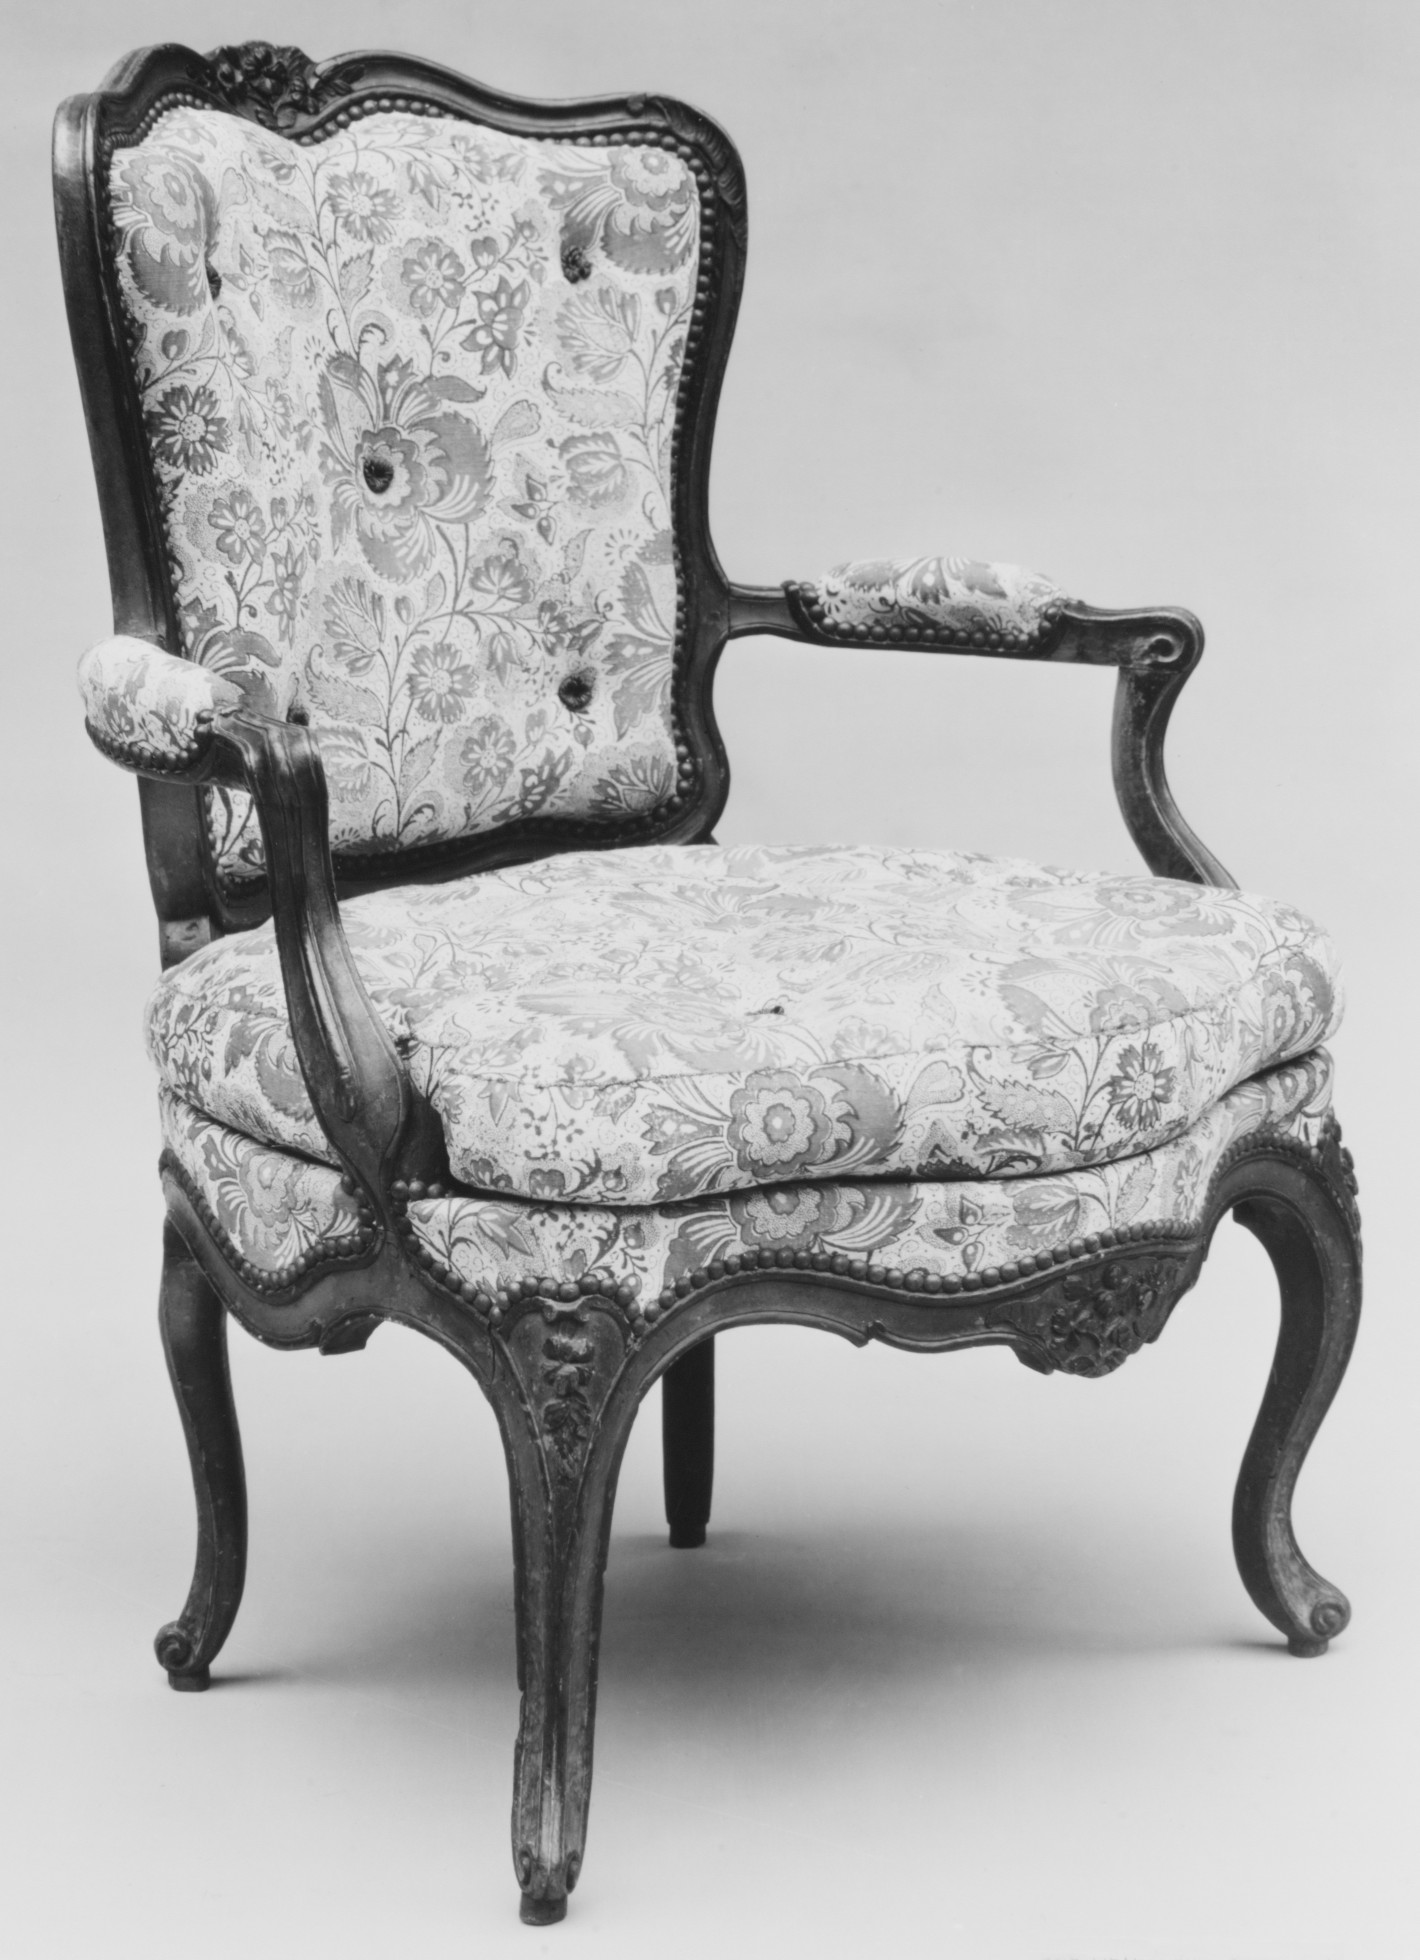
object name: armchair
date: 1701-1800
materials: wood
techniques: carving, painting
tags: flowers